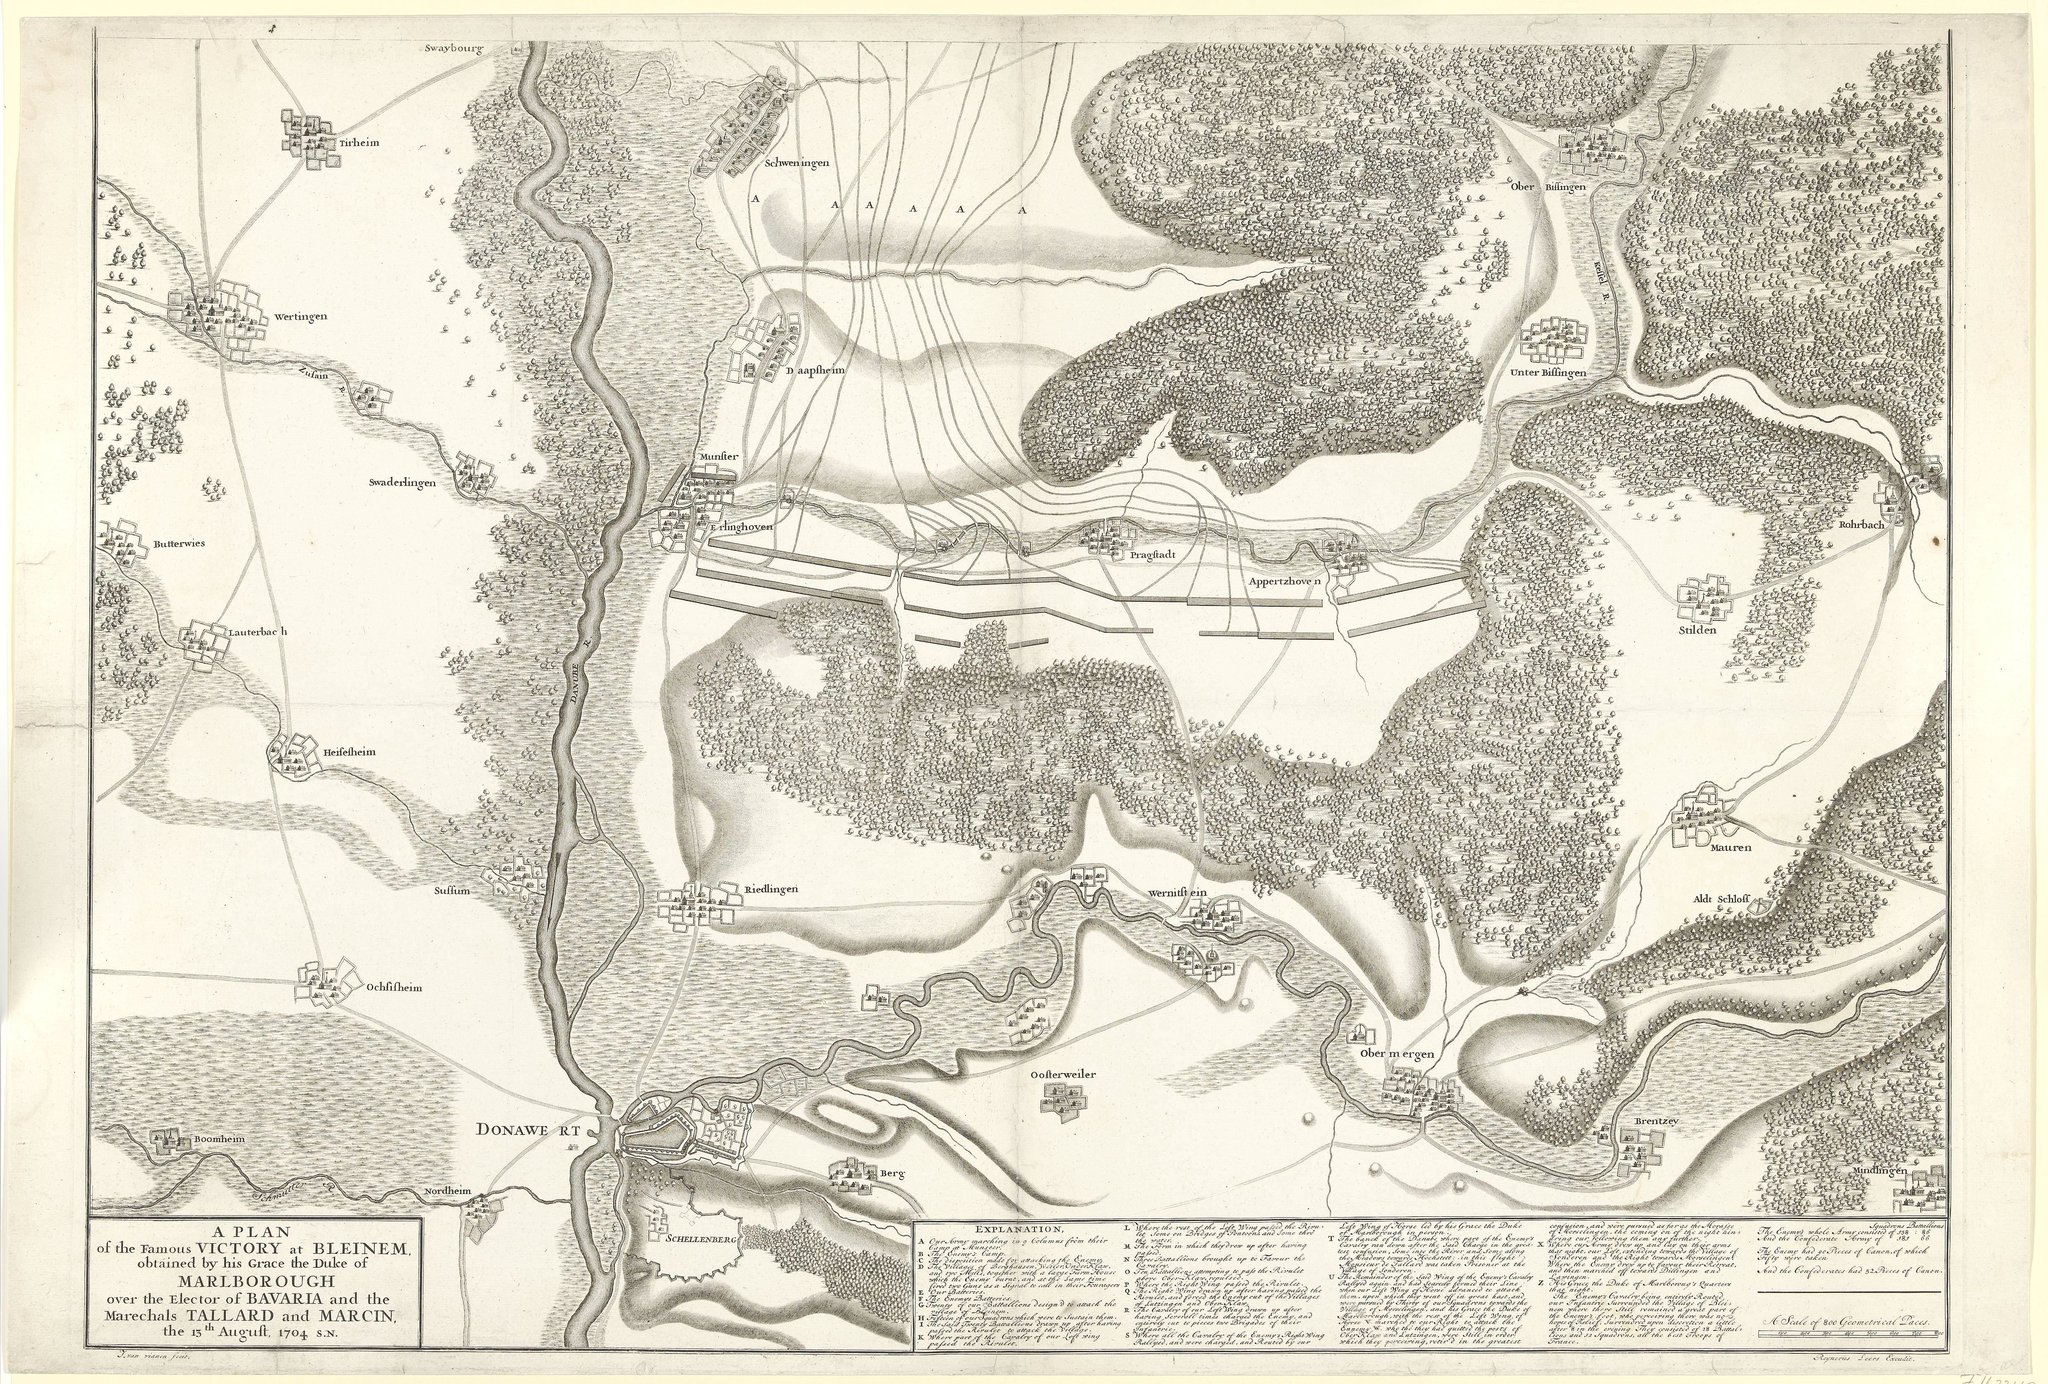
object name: map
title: A Plan of the Famous Victory at Bleinem, obtained by his Grace the Duke of Marlborough over the Elector of Bavaria and the Marechals Tallard and Marcin, the 13th Augus, 1704 S.N.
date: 1704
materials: paper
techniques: engraving, etching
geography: northern netherlands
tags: john churchill (1e hertog van marlborough), maps of separate countries or regions, battle (+ land forces)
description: Onderste helft van een grote kaart van de Slag bij Höchstädt (Slag bij Blenheim) op 13 augustus 1704 waarbij de Geallieerden onder de hertog van Marlborough en de prins van Savoye een overwinning behaalden op de Franse en Beierse troepen. Onderaan de verklaring van de letters A-Z in het Engels.